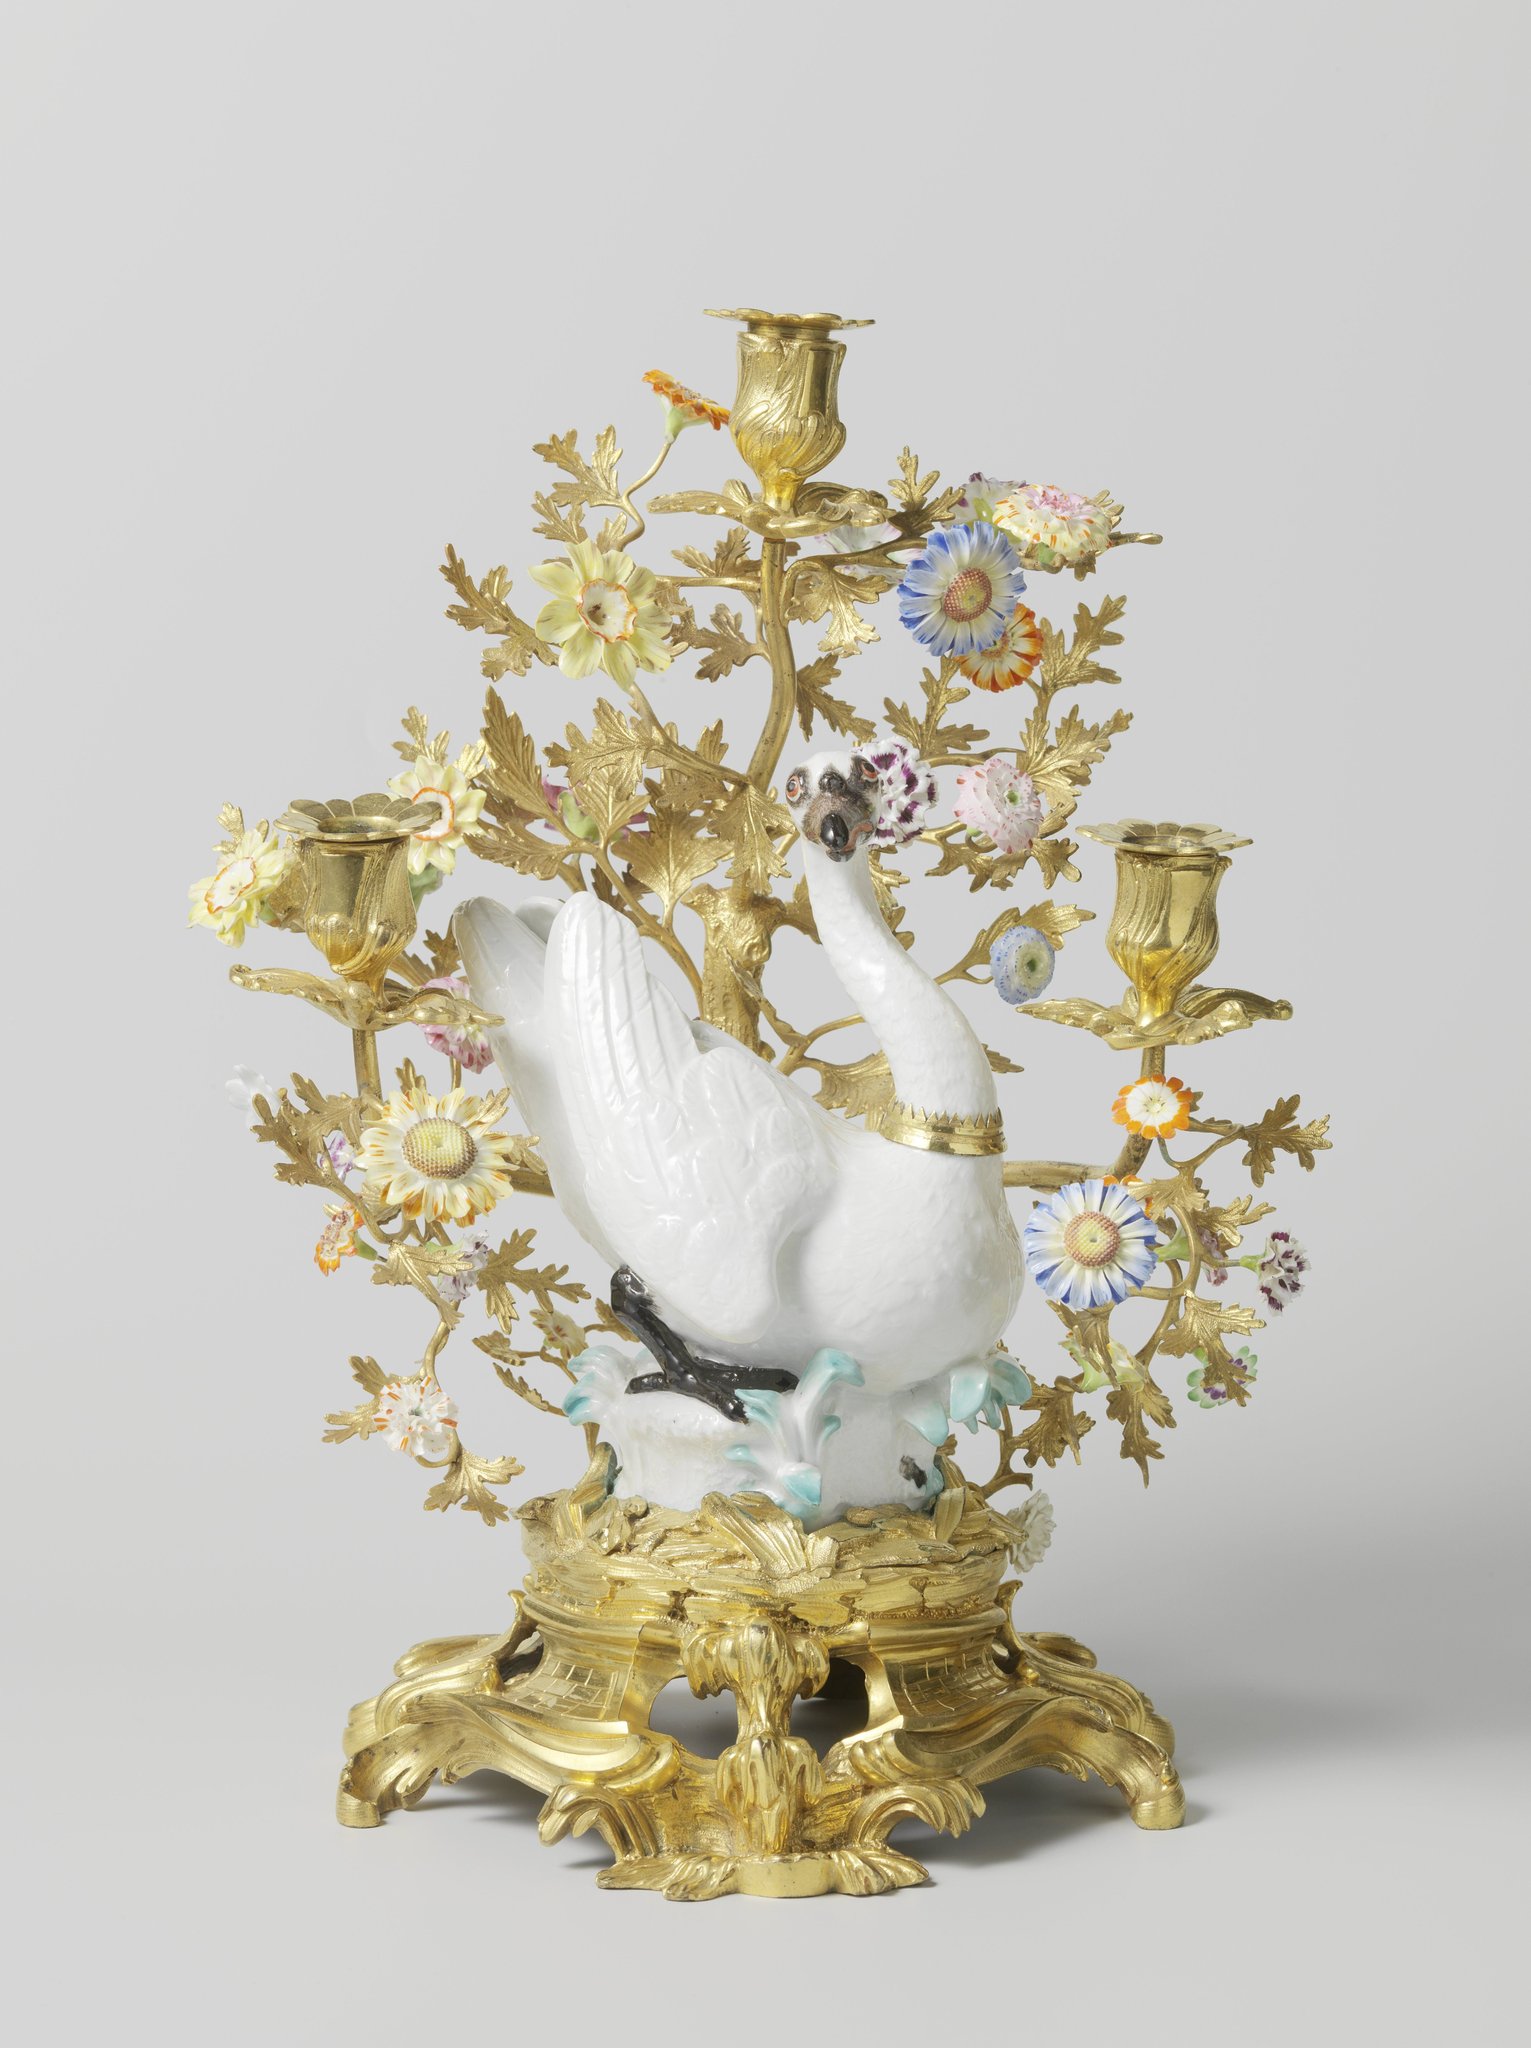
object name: candelabrum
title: Two candelabra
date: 1748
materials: bronze, paint, porcelain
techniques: gilding, painted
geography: vincennes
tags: water-birds: swan, flowers: rose, ornament derived from plant forms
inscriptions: factory mark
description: These porcelain swans are small versions of the famous large porcelain birds from the Meissen porcelain factory. From 1749 onwards, the successful Paris dealer Lazare Duvaux had several pairs of similar swans fashioned into candelabra. This pair may have come from his shop.